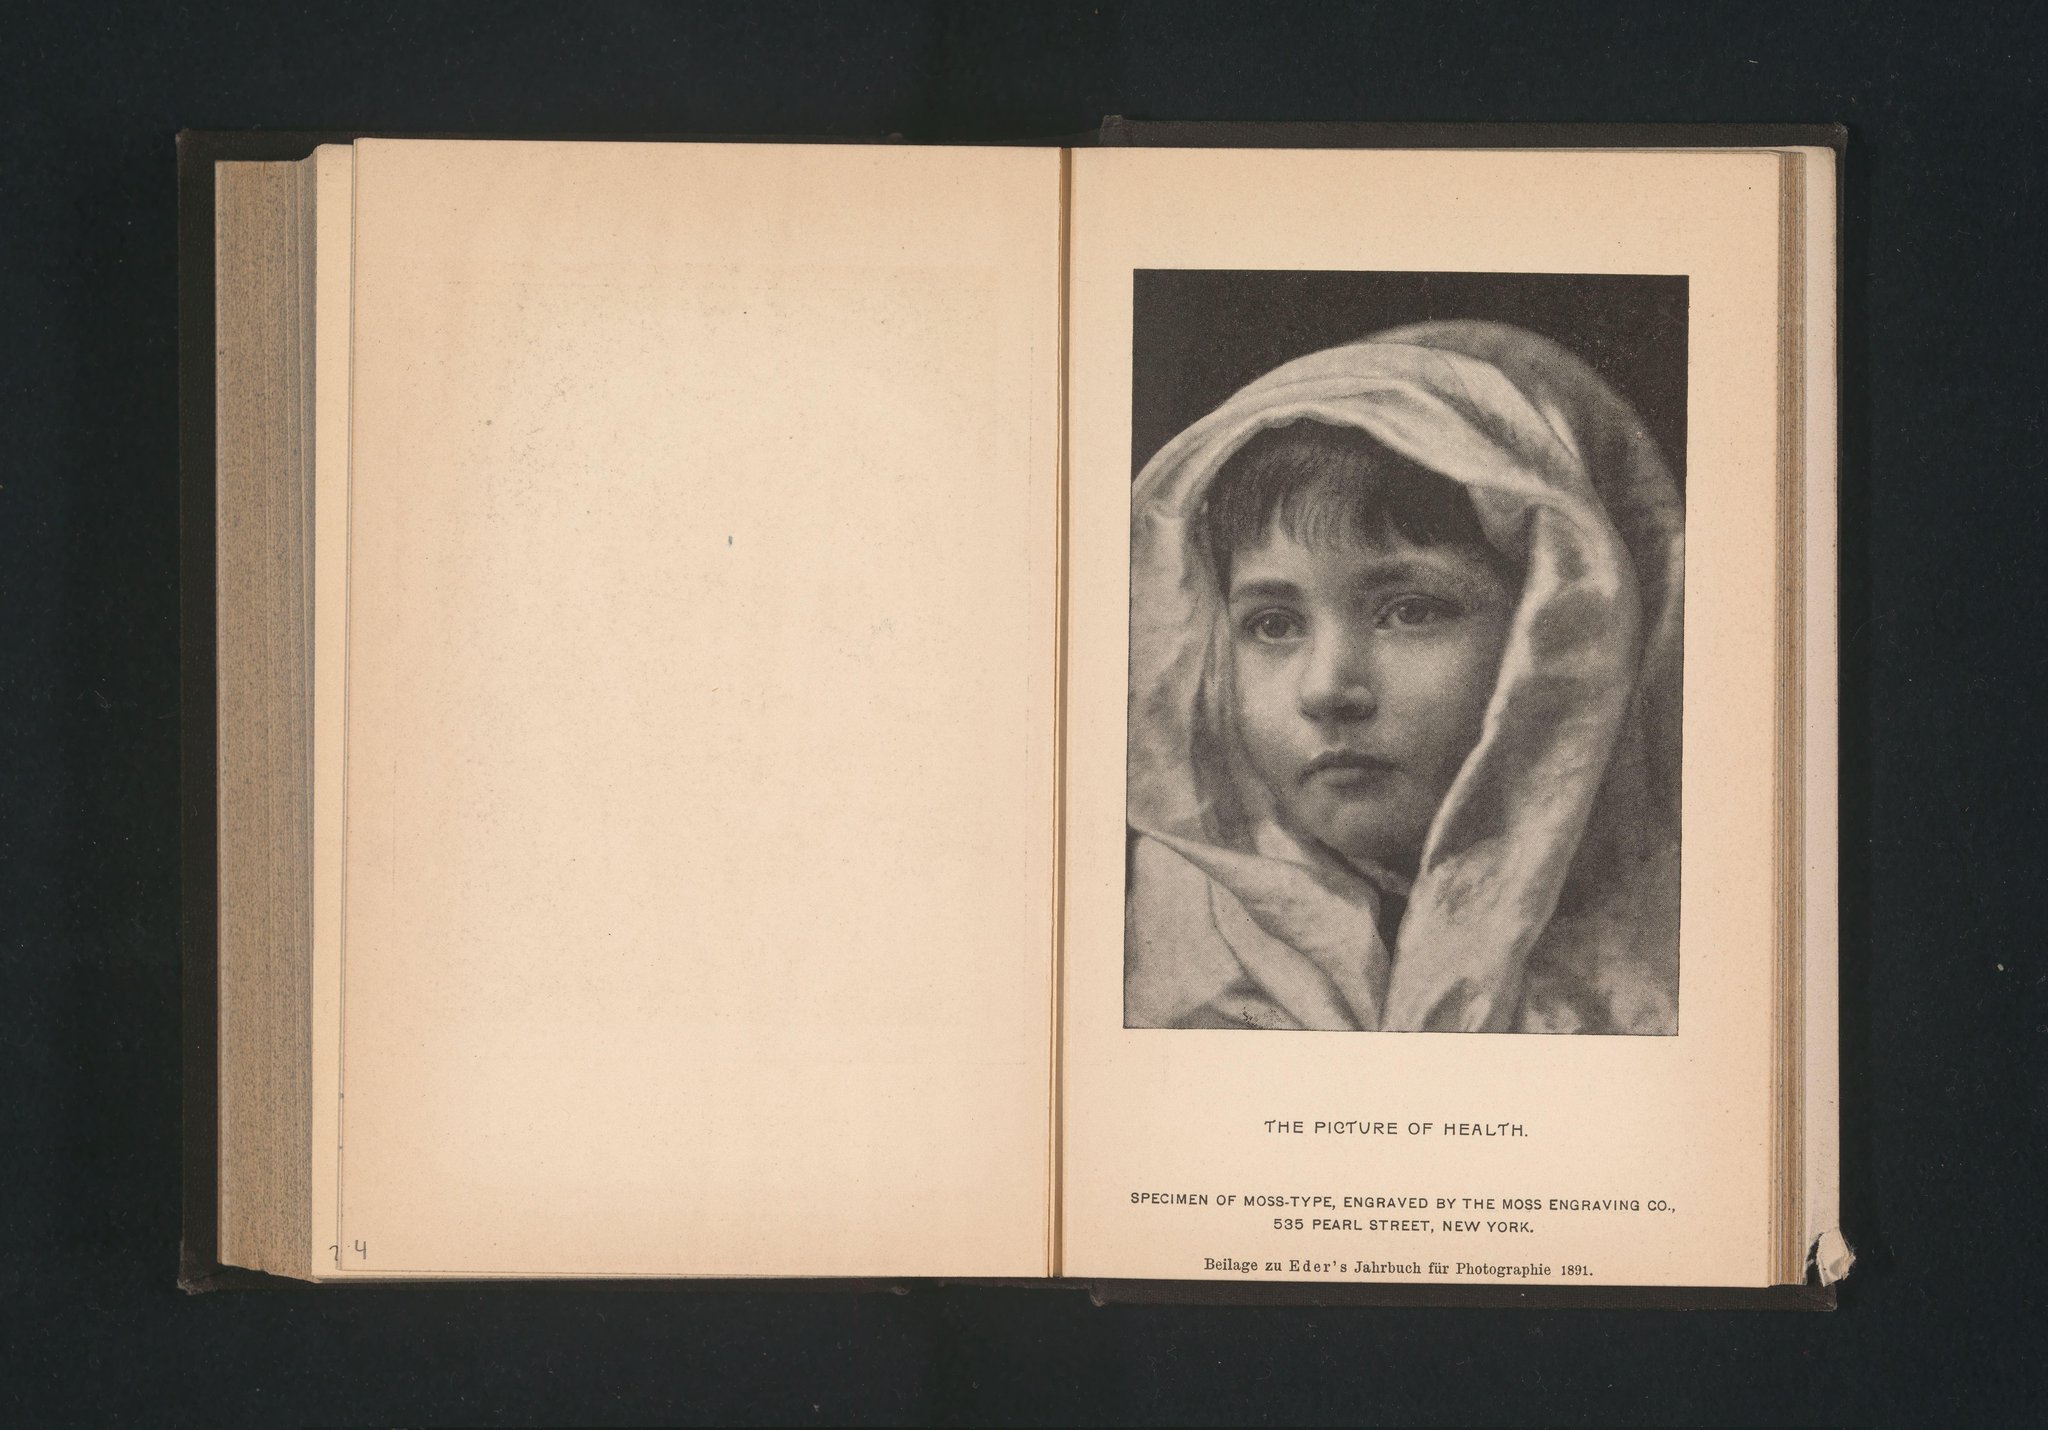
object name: photomechanical print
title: The picture of health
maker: Anonymous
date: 1886-1891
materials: paper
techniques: autotype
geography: new york city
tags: child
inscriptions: inscription: ‘Beilage zu Eder's Jahbruch für Photographie 1891’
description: Prent op twaalfde ongenummerde pagina na pagina 627.